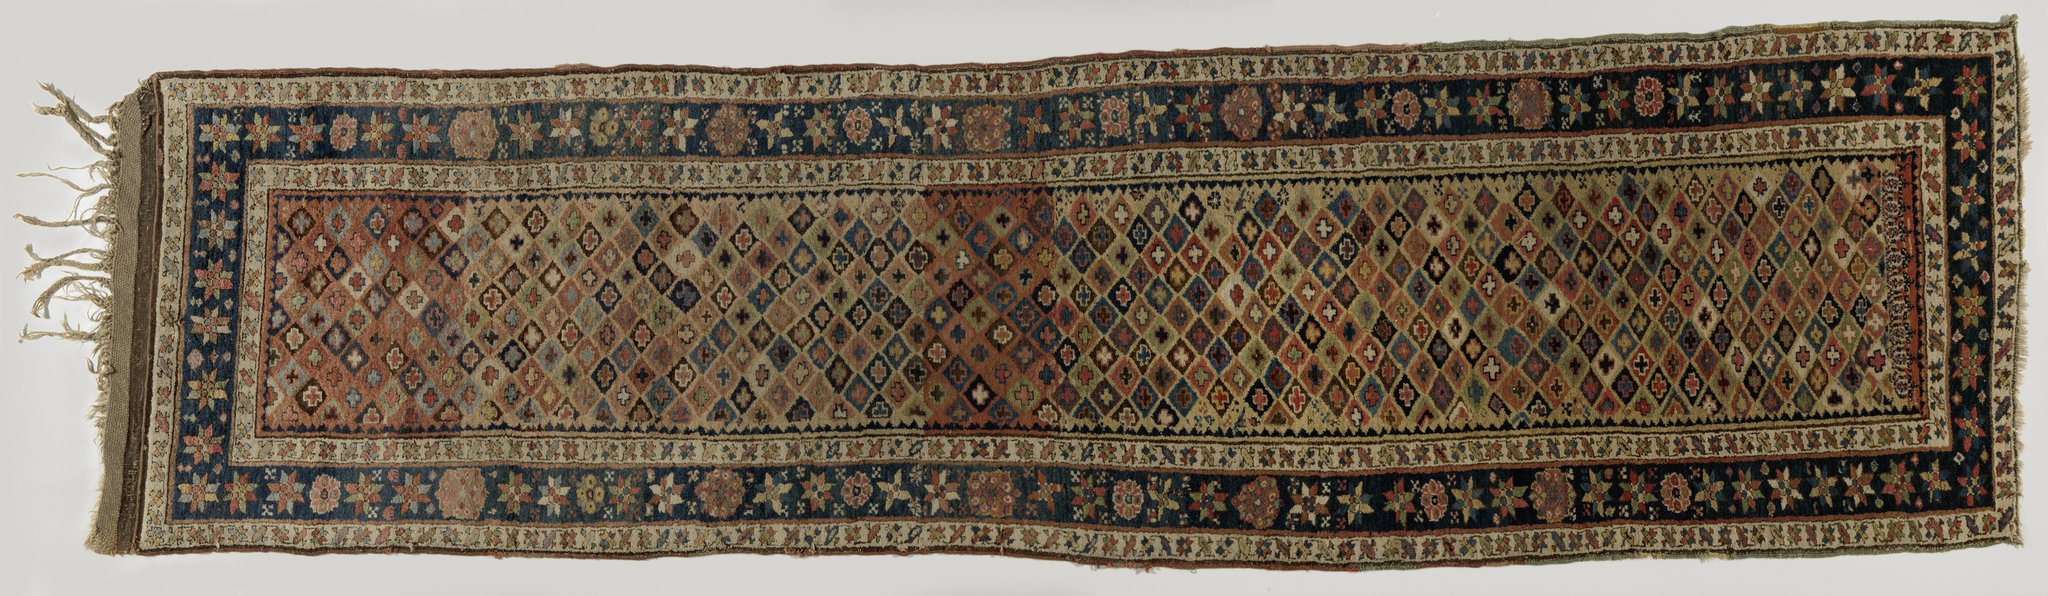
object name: oriental rug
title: Ruitenkleed. Middenveld met rasterwerk waarbinnen kruisvormige geometrische ornamenten. Blauwe rand met achtpuntige sterren en voluutrozetten.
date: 1800-1900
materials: wool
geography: kurdistan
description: Oosters tapijt, ruitenkleed. In het middenveld een ruitvormig raster met kruisvormige geometrische ornamenten. De blauwe rand is versierd met achtpuntige sterren en voluutrozetten.